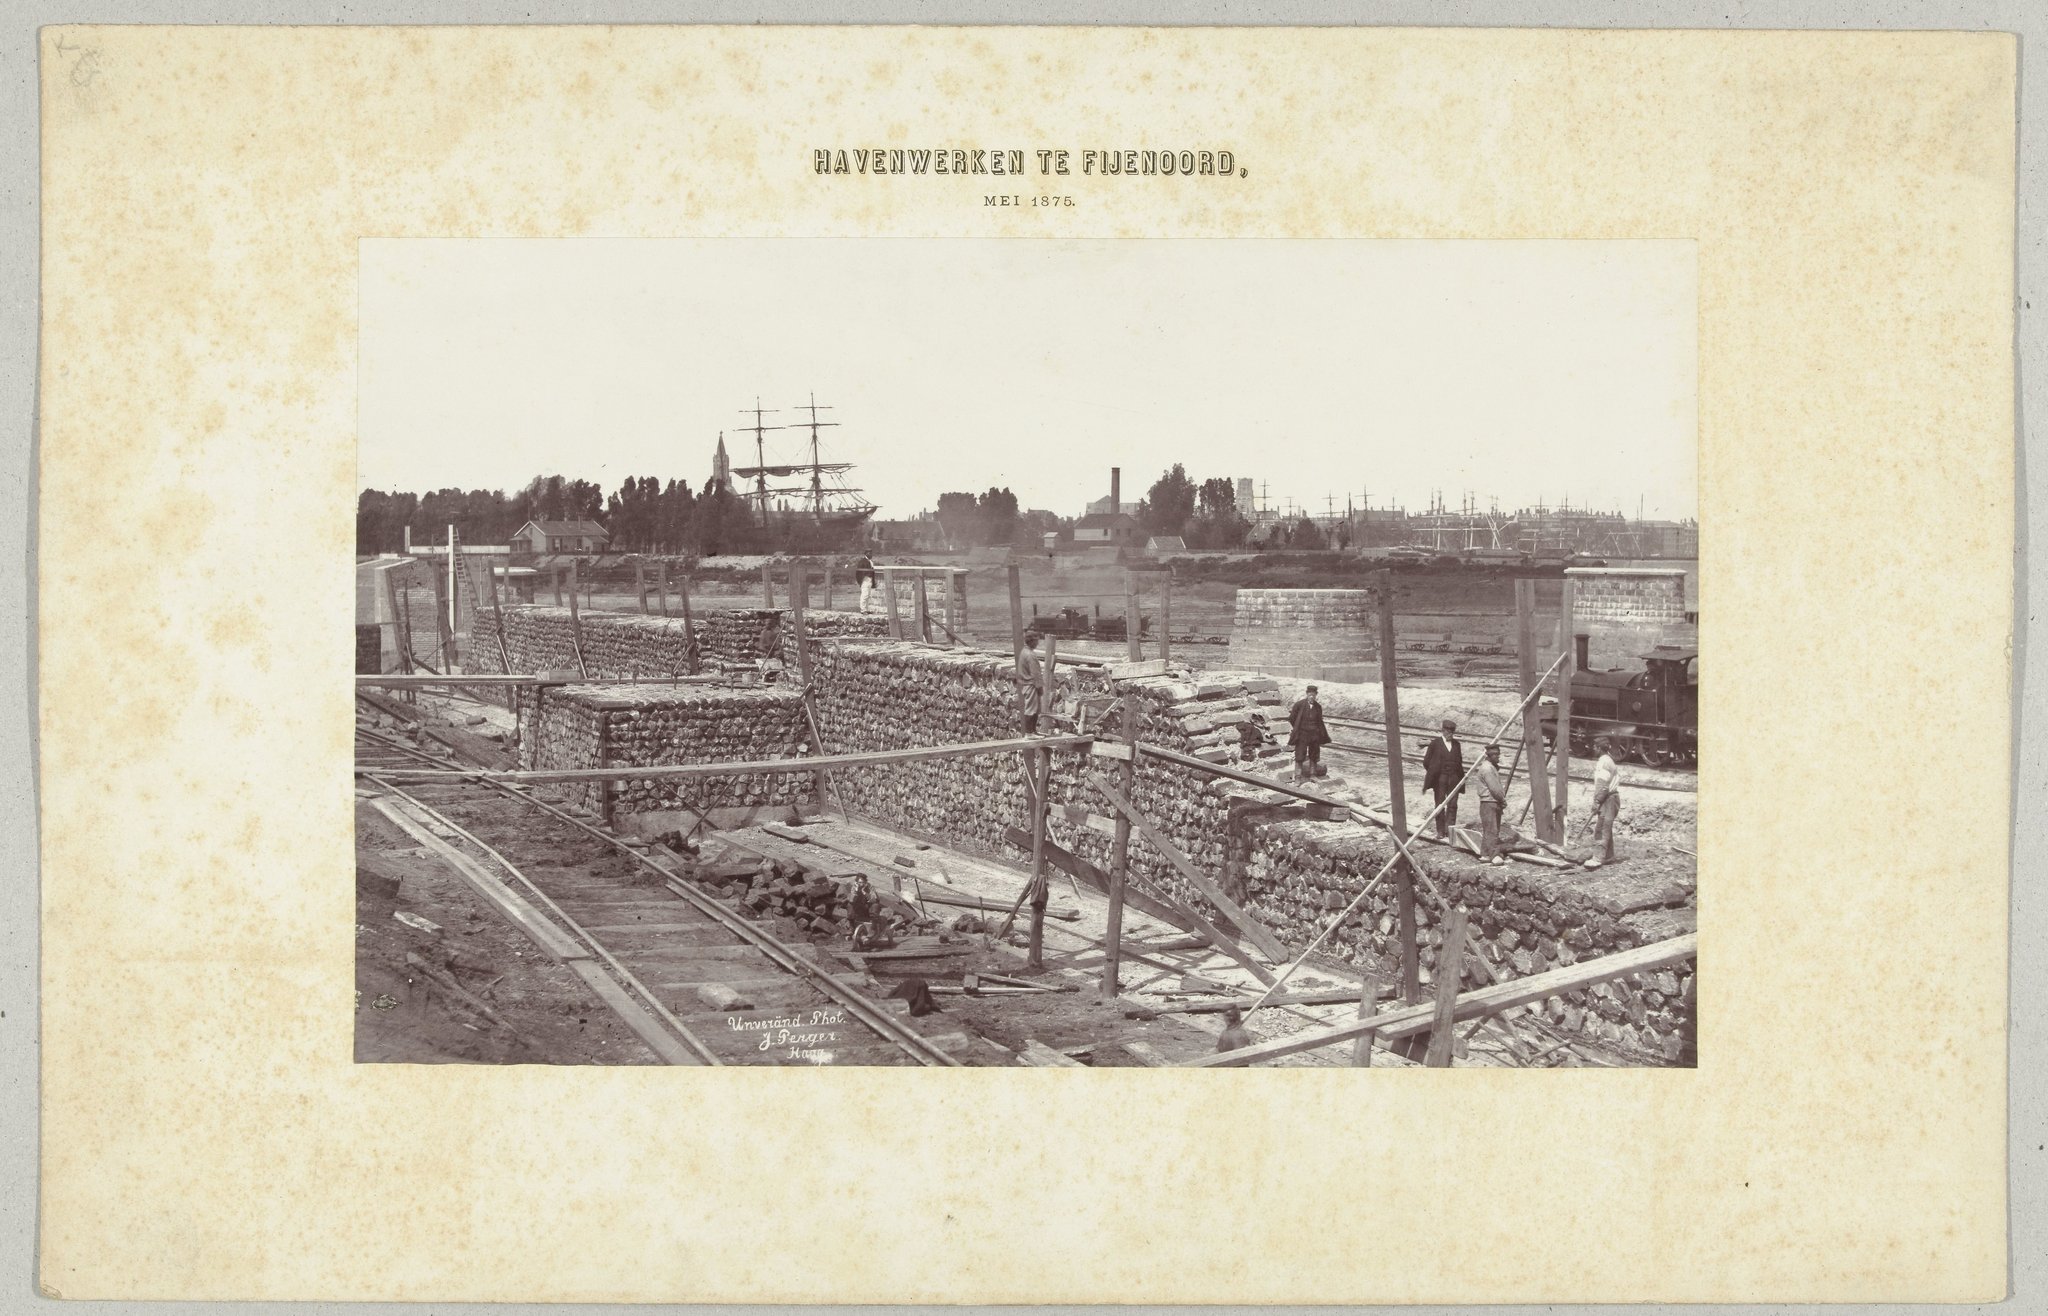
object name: photograph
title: Aanleg havenwerken Feijenoord, Rotterdam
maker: julius perger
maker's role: fotograaf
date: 1805-1875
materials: paper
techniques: carbon print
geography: rotterdam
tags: harbour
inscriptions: name: ‘Unverand Phot J Perger Haag.’, title: ‘Havenwerken te Fijenoord mei 1875’